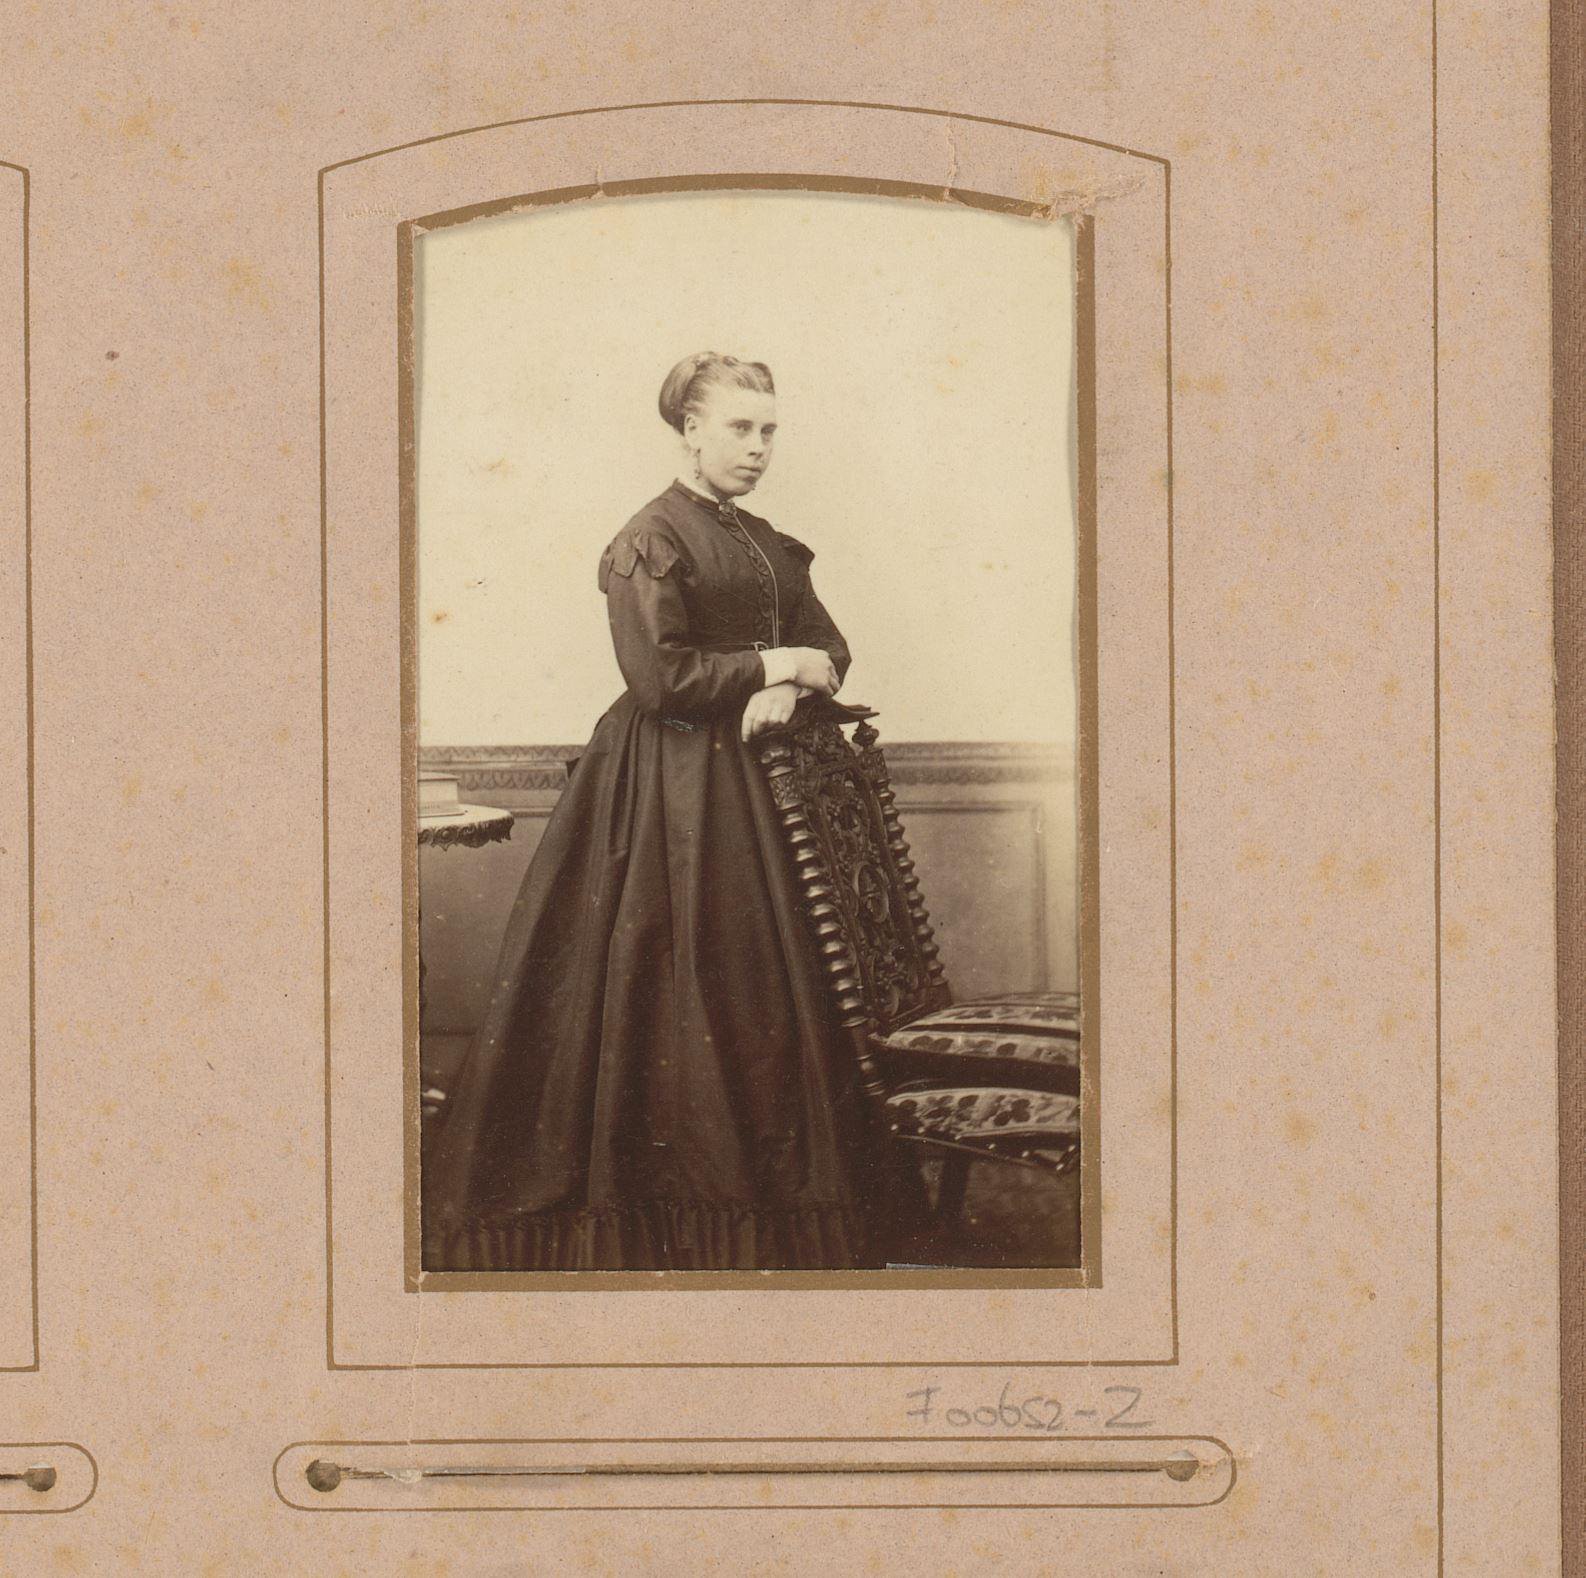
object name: photograph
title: Portret van een vrouw, staand bij een stoel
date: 1860-1880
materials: cardboard, photographic support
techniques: albumen print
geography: great yarmouth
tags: historical persons - bb - woman, chair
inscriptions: inscription: ‘"Carte de Visite" Studio,/ Regent Road./ Great Yarmouth/ J. Pearce Ford,/ Propr./ No./ Further Copies to Order.’